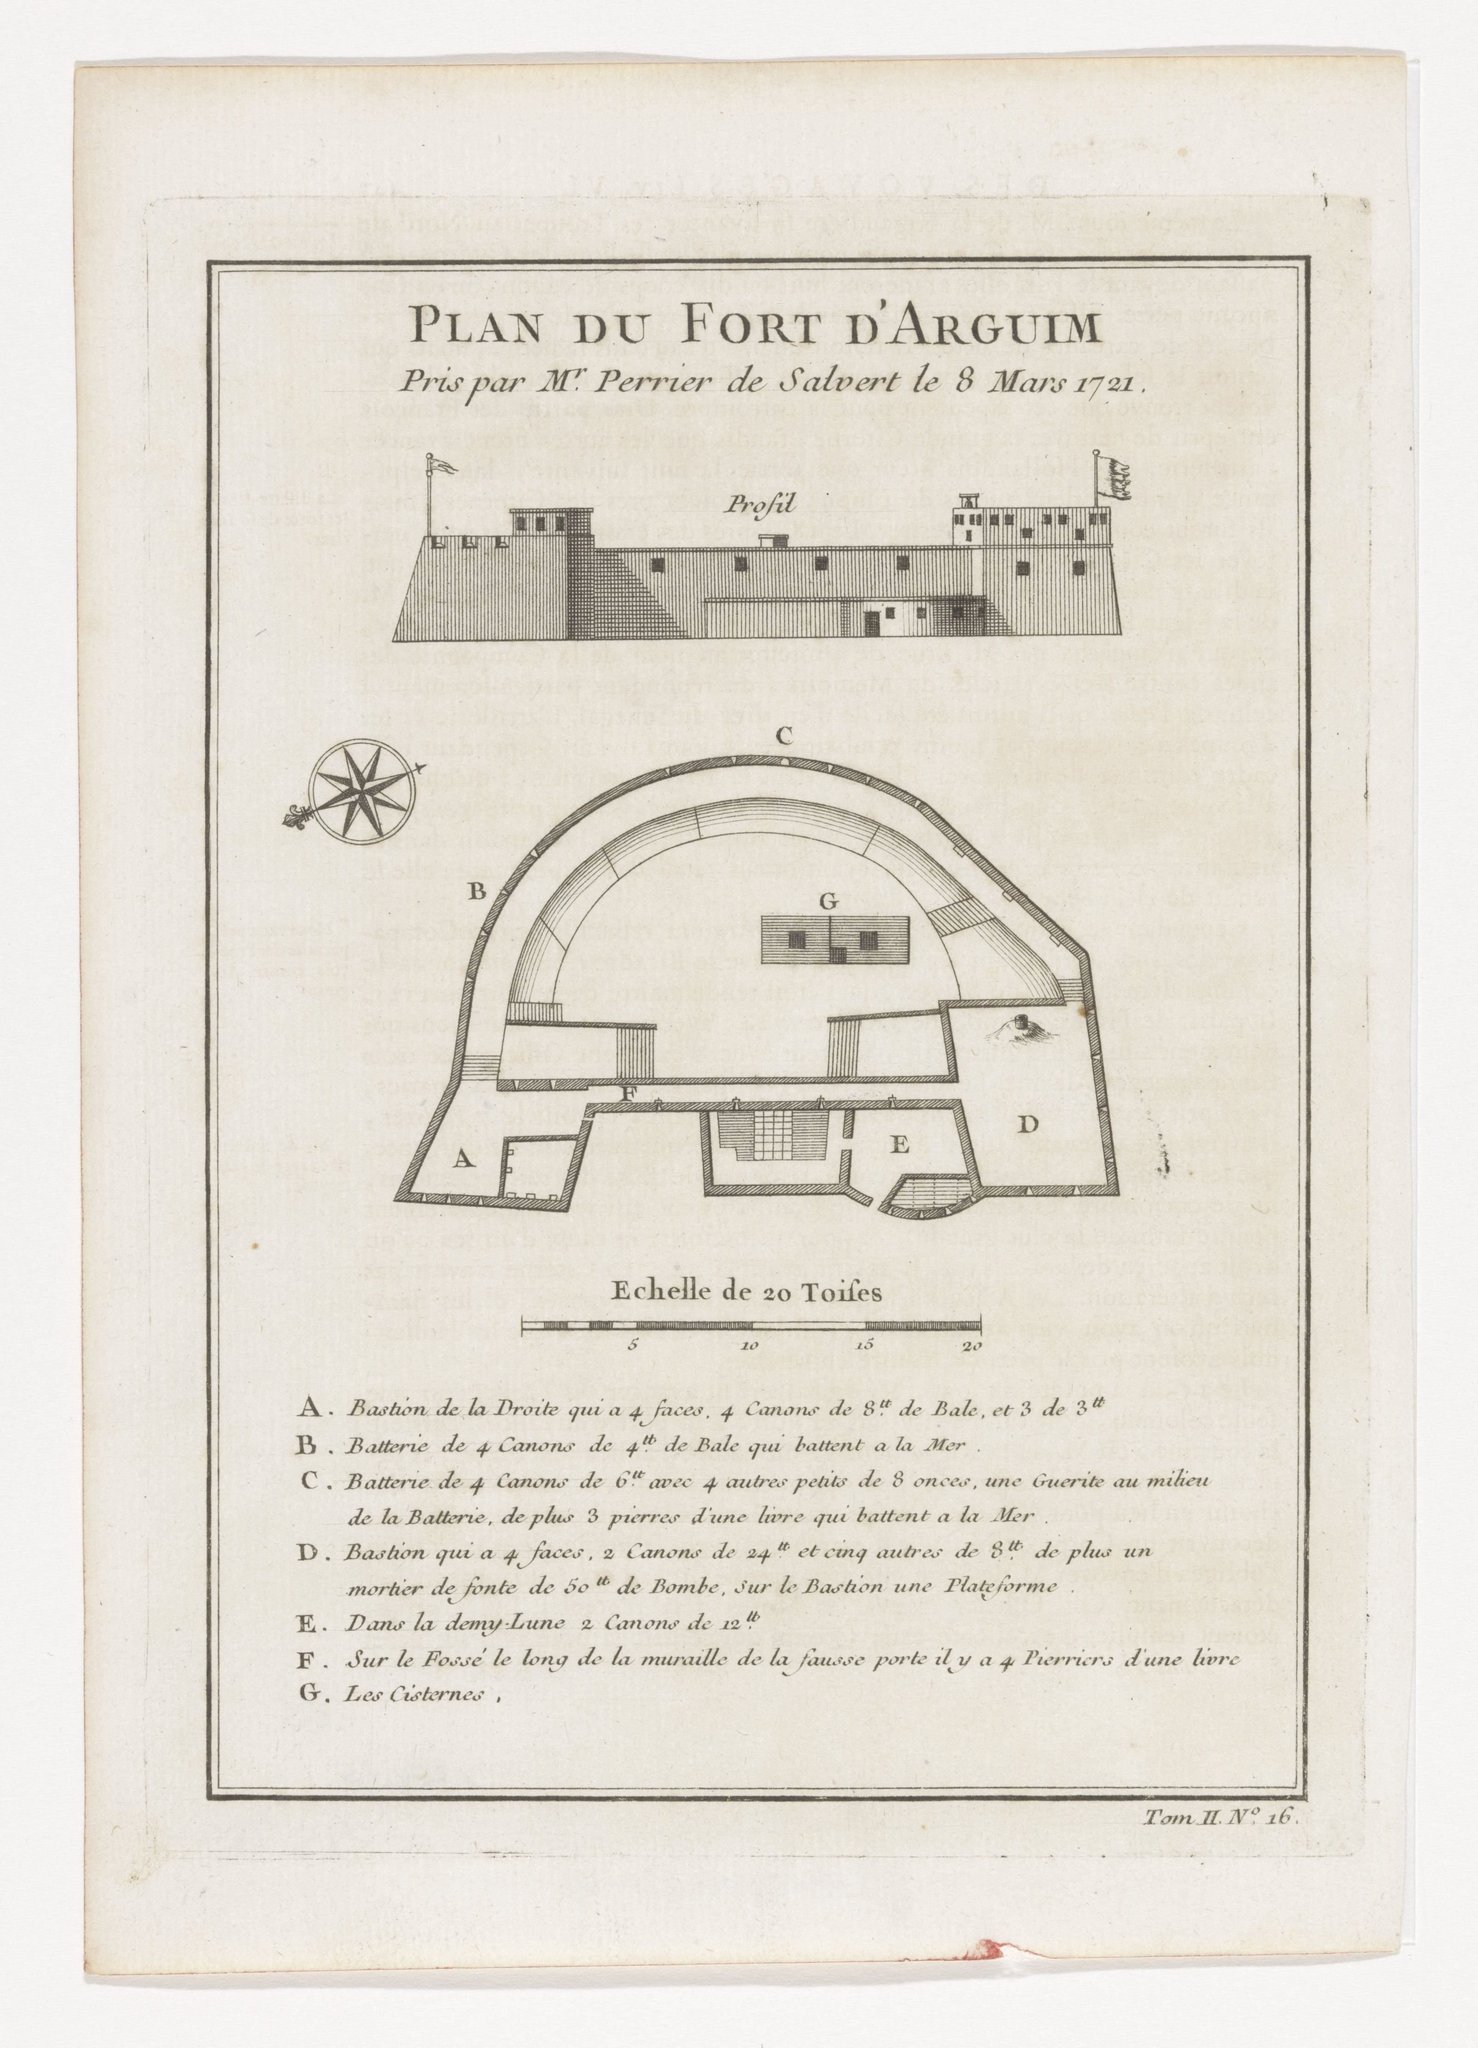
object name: print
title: Plattegrond en aanzicht van het fort te Arguin (Mauretanië)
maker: Anonymous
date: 1746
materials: paper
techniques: etching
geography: france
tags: verenigde oostindische compagnie, arguin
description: Gebruikt als illustratie in: A.F. Prévost, Histoire générale des voyages, ou Nouvelle collection de toutes les relations de voyages par mer et par terre ..., 20 dln 1746-1789, dl. II, Parijs: Didot, 1746.